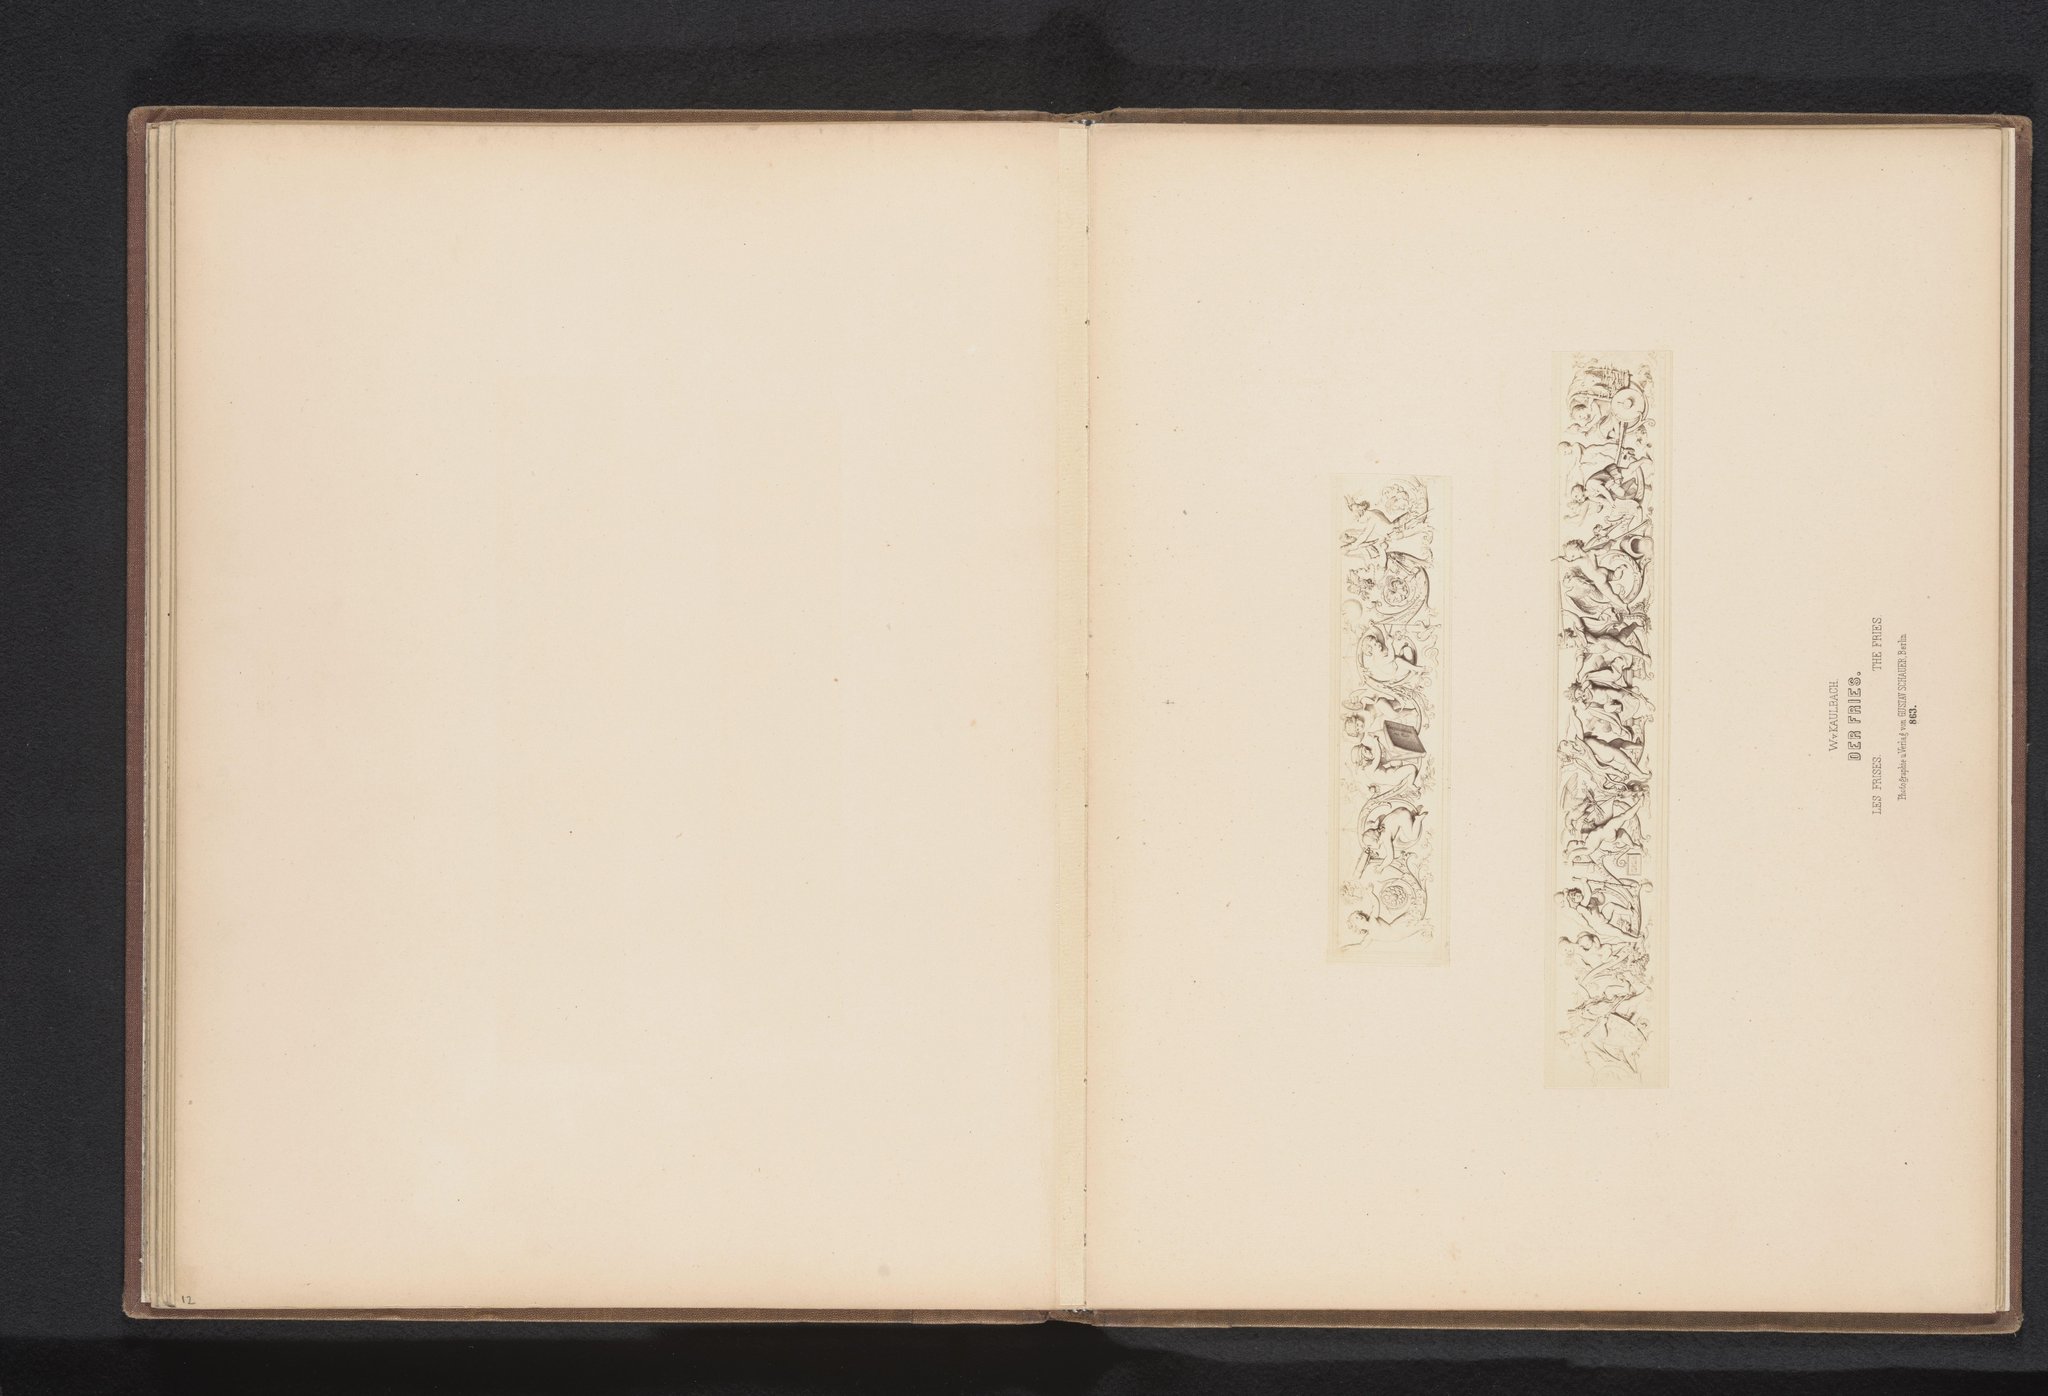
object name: photograph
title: Fotoreproducties van twee tekeningen voor decoratieve friezen voor wandschilderingen voor het trappenhuis van het Neues Museum in Berlijn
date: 1860-1870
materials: photographic support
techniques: albumen print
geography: berlin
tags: wall-covering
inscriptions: number: ‘863.’